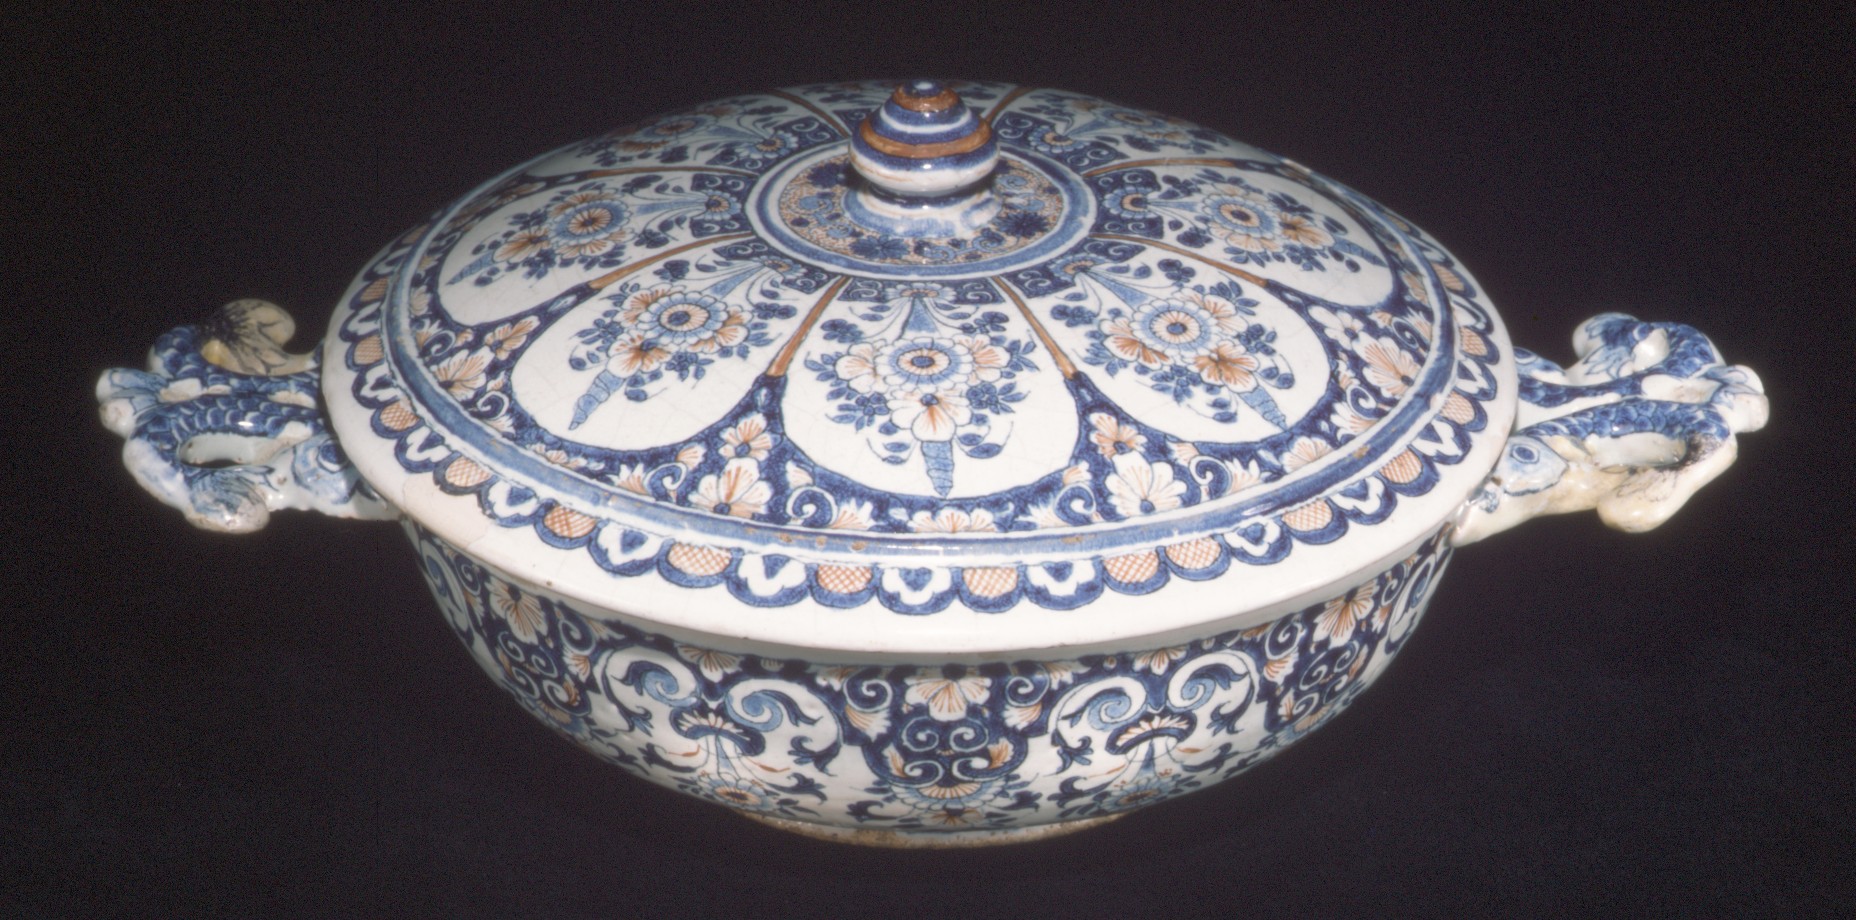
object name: bowl with cover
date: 1705-1720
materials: faience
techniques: glazing